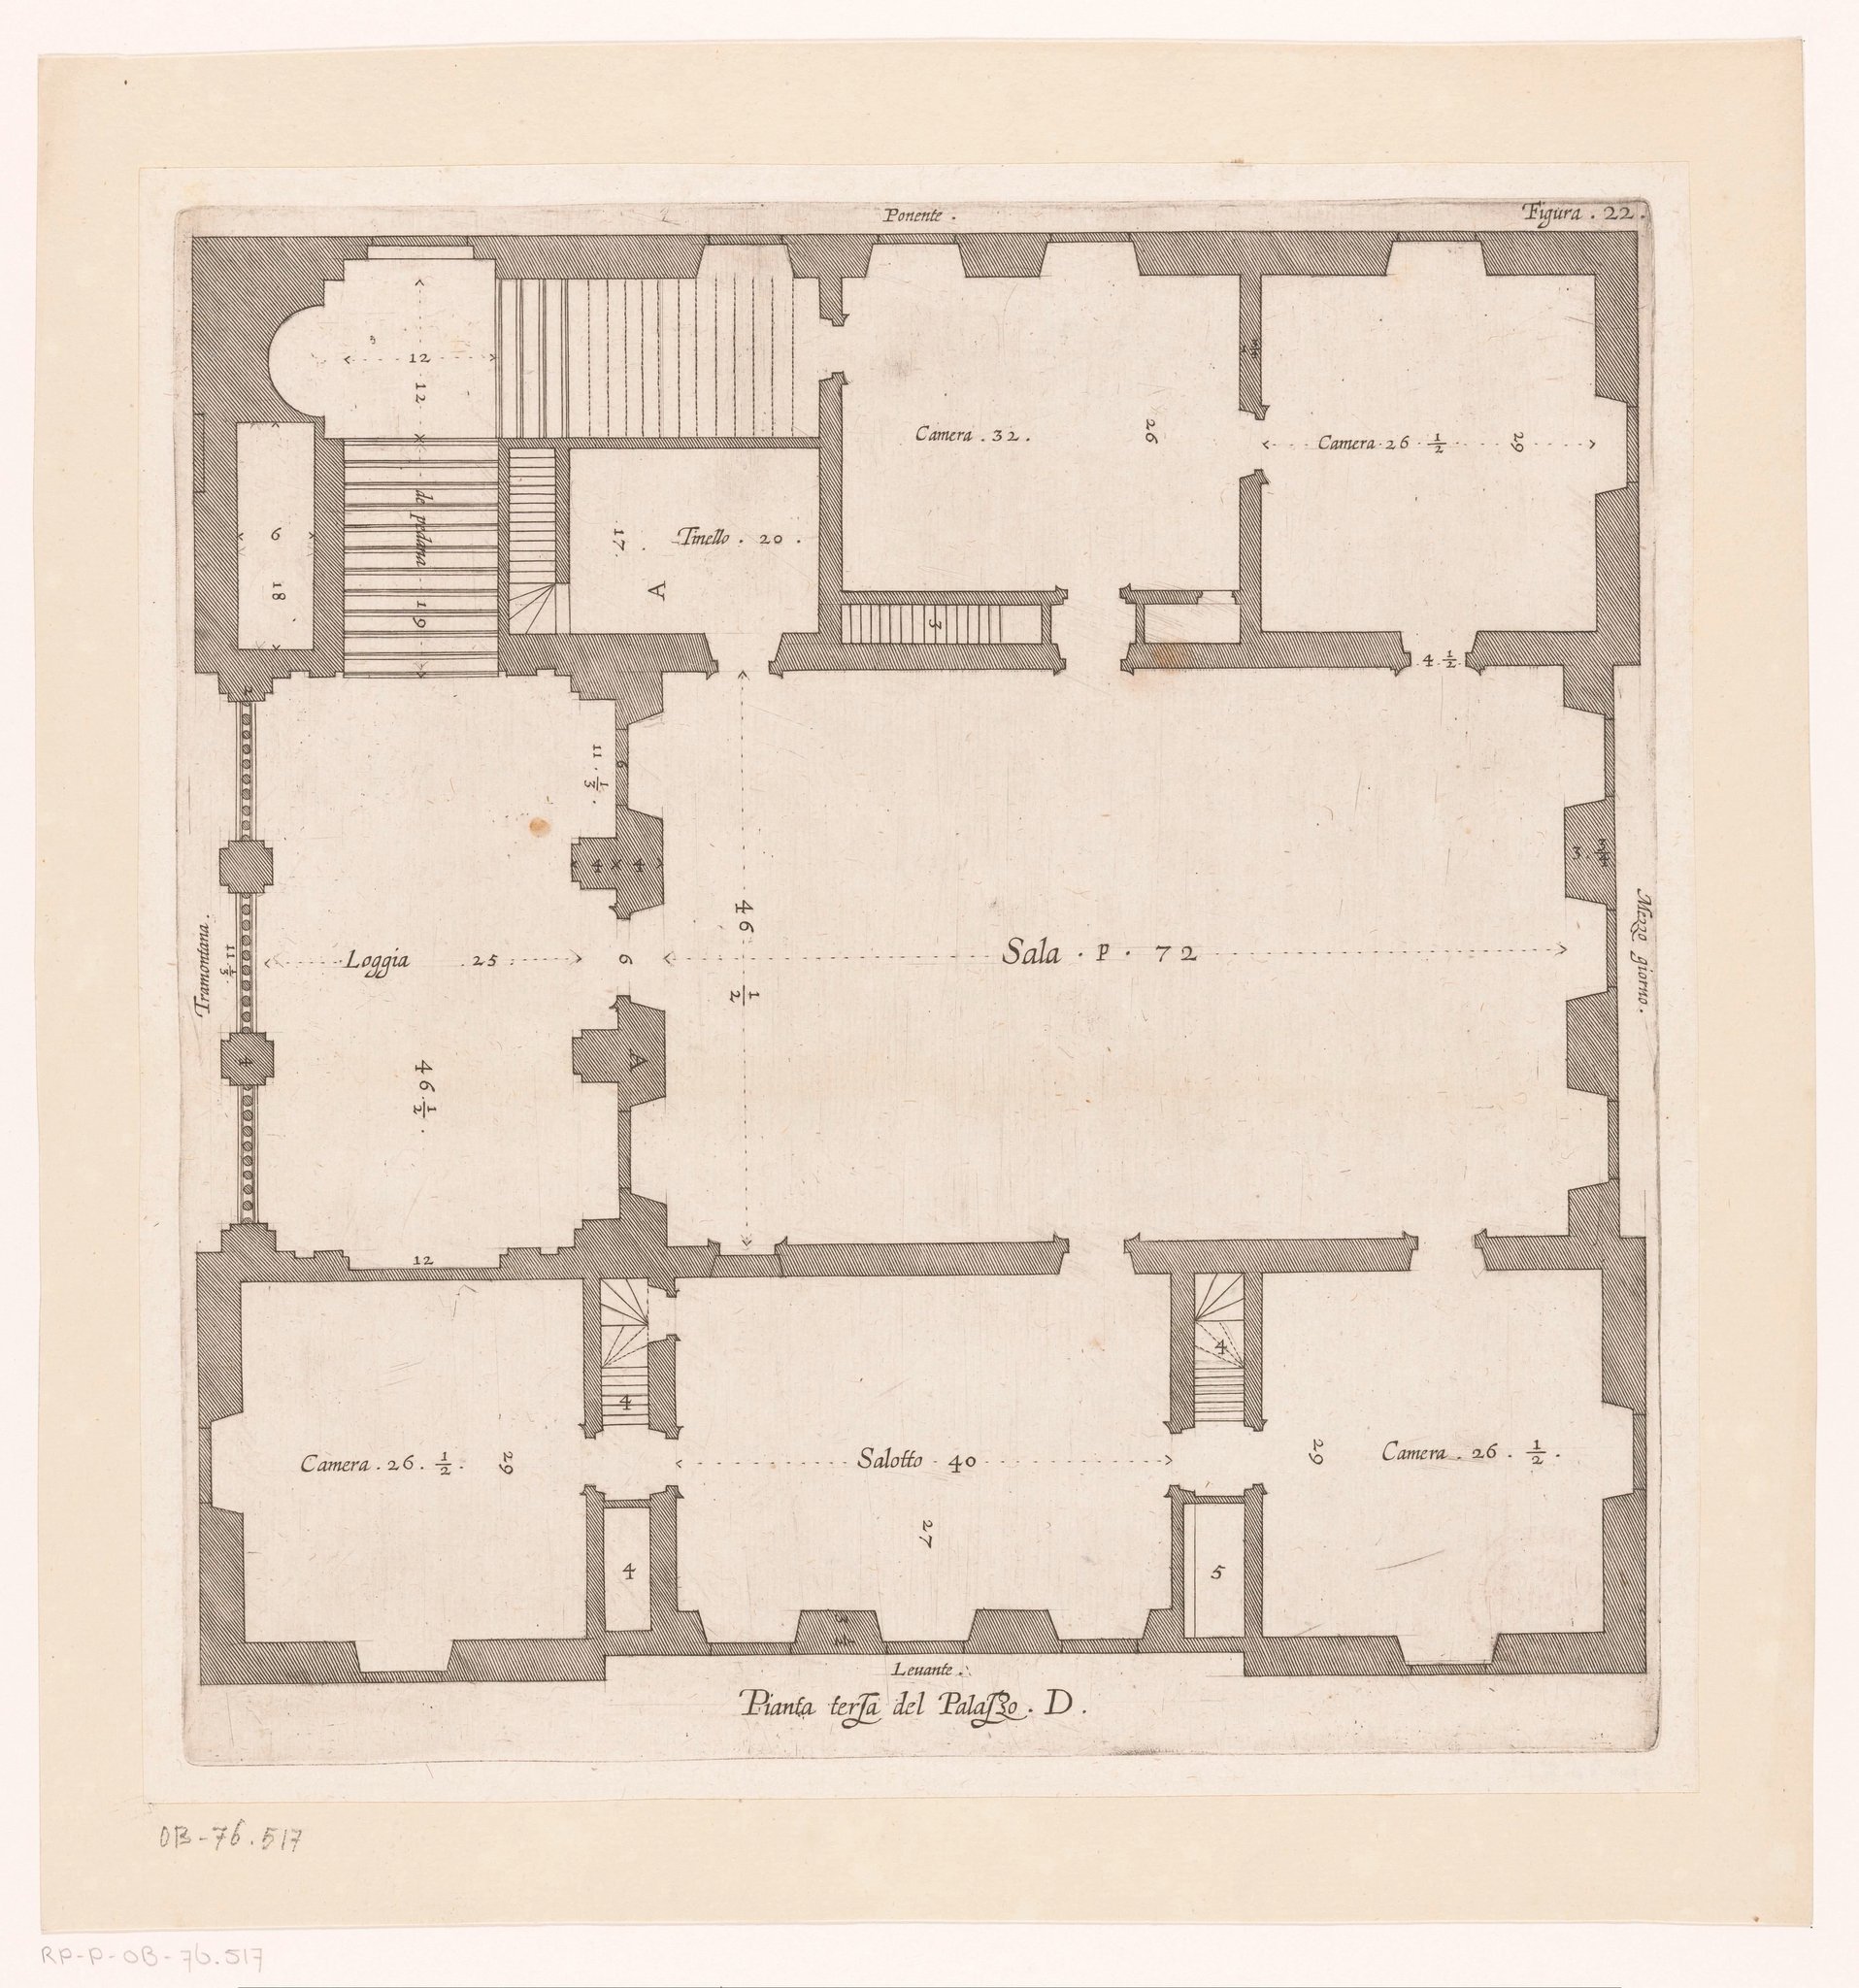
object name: print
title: Plattegrond van de eerste verdieping van de Villa Grimaldi te Genua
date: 1622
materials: paper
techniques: engraving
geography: antwerp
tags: hôtel, i.e. small palace in city - aa - civic architecture: inside, plan ~ architecture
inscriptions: collector's mark: Lugt 240